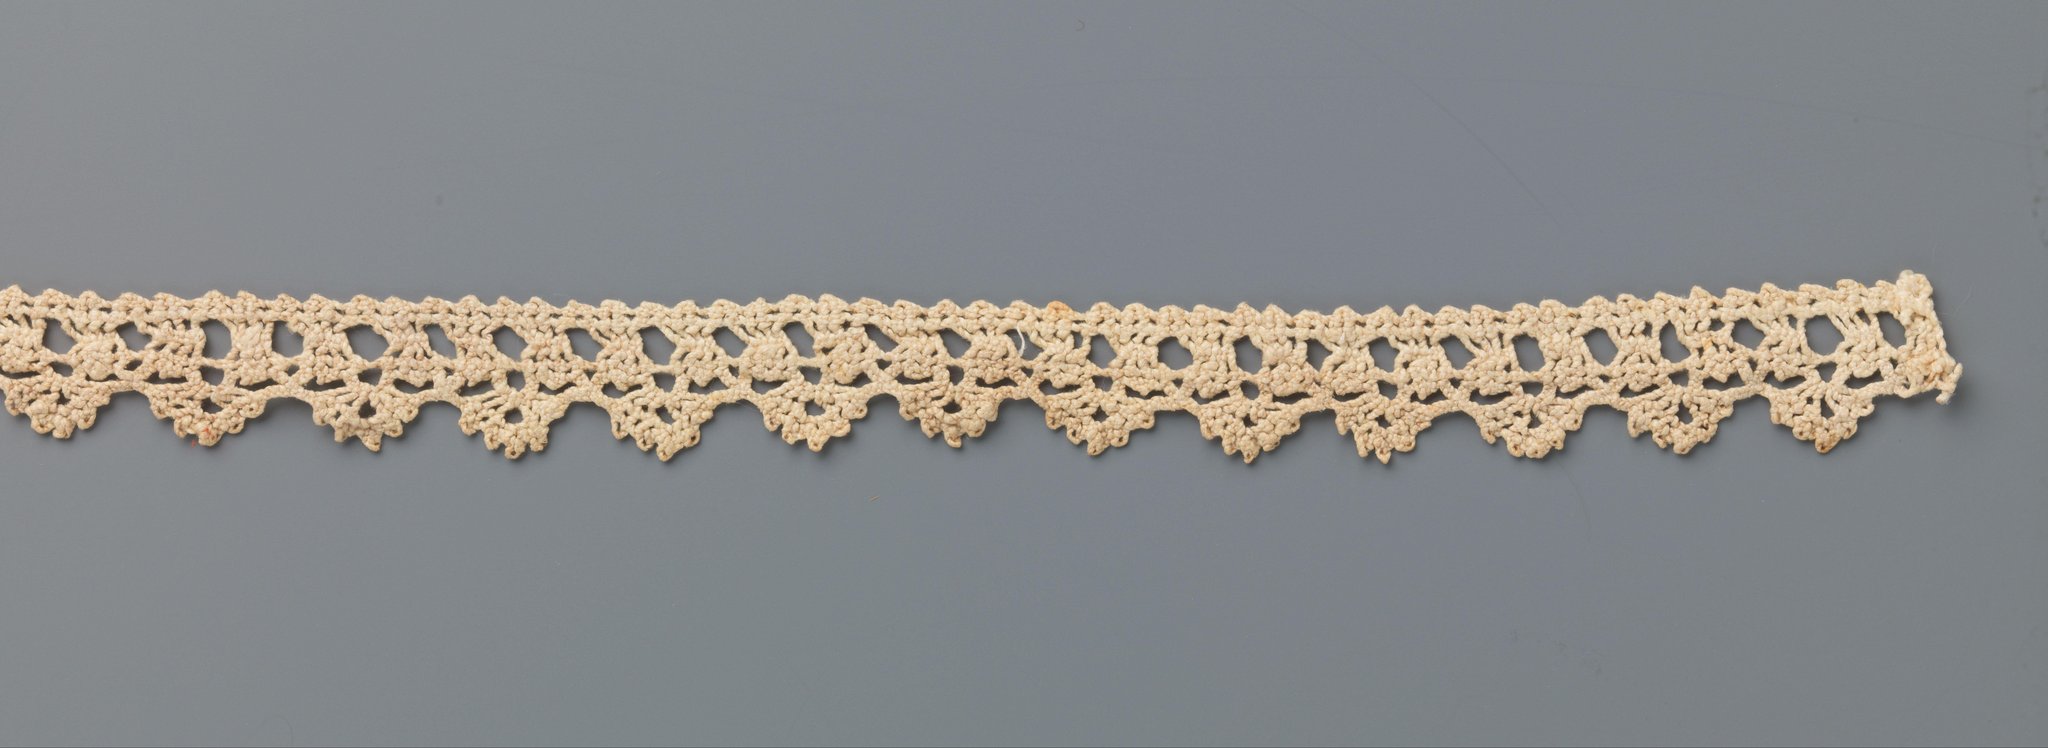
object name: strip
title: Strook kloskant met waaiervormige schulpjes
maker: Anonymous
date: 1600-1649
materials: linen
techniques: lace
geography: southern netherlands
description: Strook naturelkleurige kloskant. Het patroon bestaat uit waaiervormige schulpjes die aan een rechte rand hangen bestaande uit gebundelde vlechtjes. Er is met een dikke draad gewerkt. De bovenzijde is afgewerkt met een rechte rand met kleine puntjes.